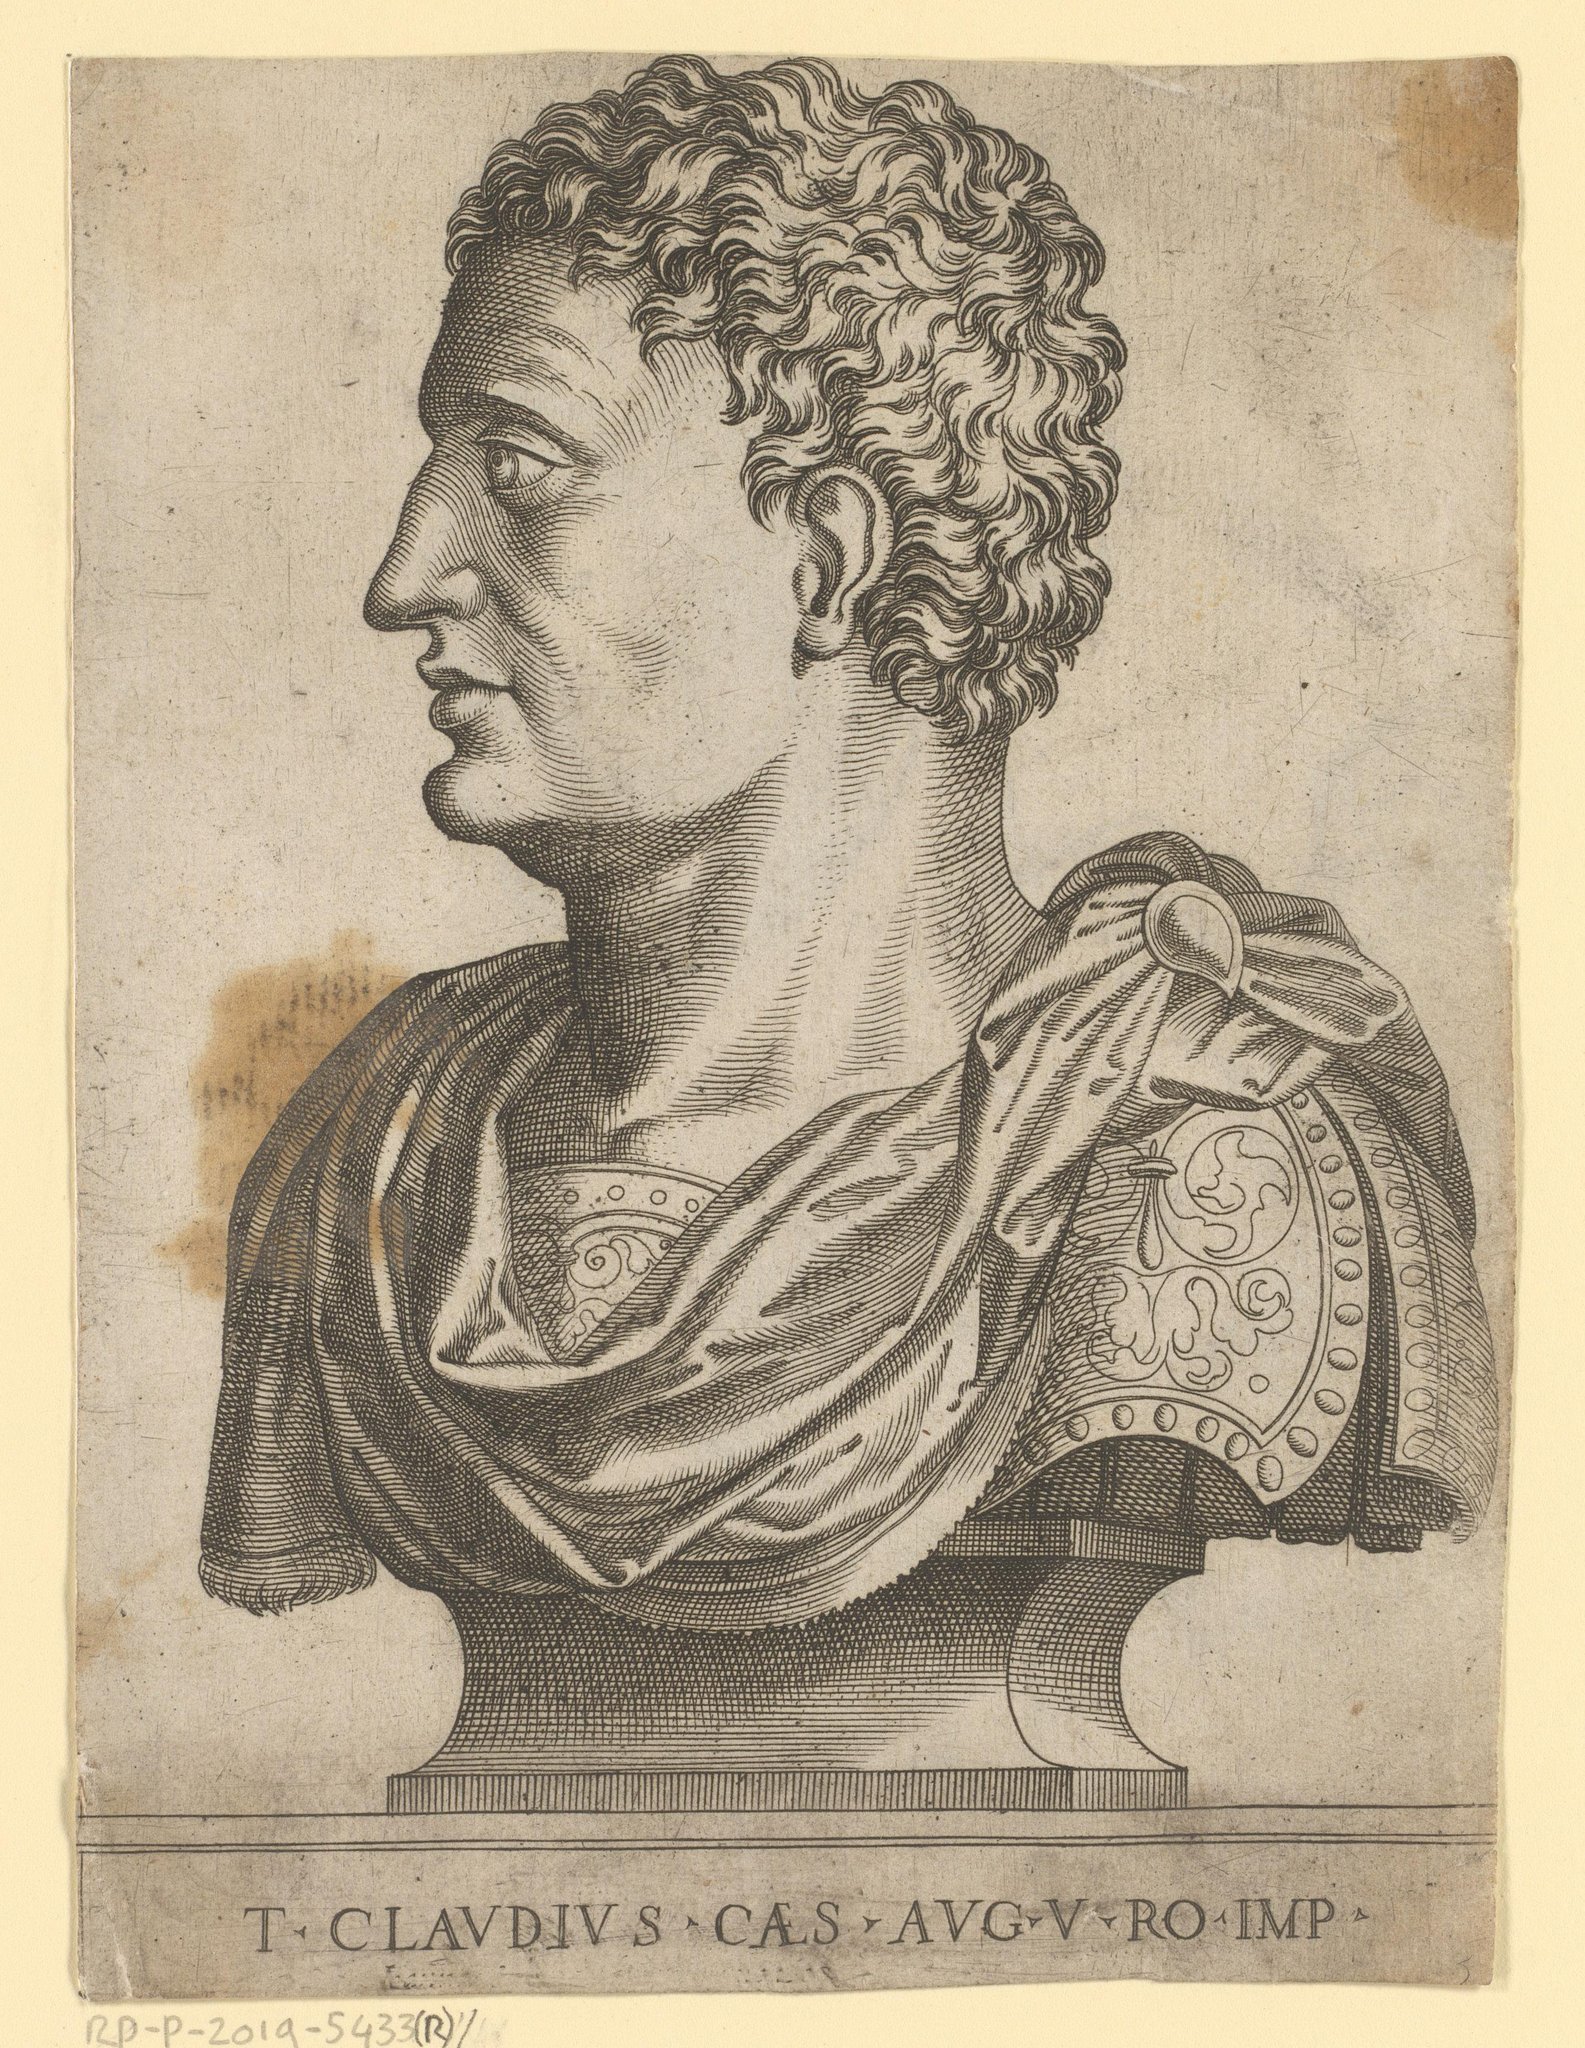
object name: print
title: Keizers van het Romeinse Rijk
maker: martino rota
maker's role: print maker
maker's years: 1520-1583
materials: paper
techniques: engraving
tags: historical persons, emperor, (story of) claudius the roman emperor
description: Prent voor het eerst gebruikt in de serie 'Imperatorum Caesarumque viginti quatuor effigies a Julio usque ad Alexandrum Severum ex antiquis marmoribus ac numismatis desumptae', gepubliceerd door Claude Duchet (zie documentatie). De prent behoort tot een latere uitgave van deze serie, van een onbekende uitgever.